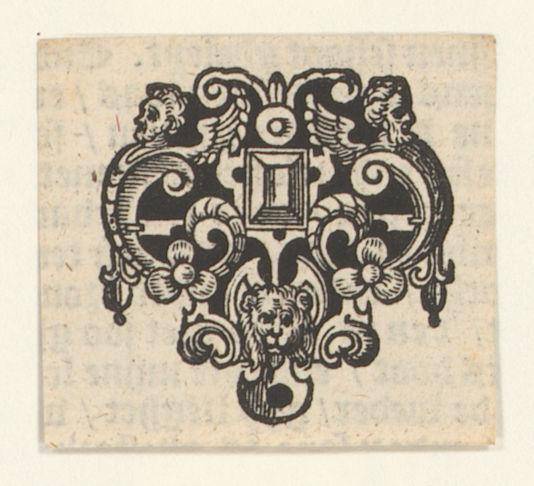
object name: album leaf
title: Ornament met twee mensenhoofden en een leeuwenkop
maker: Anonymous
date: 1592-1645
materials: paper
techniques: letterpress printing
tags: lion's head ~ ornament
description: Deze prent is gebruikt als ornament in: Paets, Pieter Jacobsz. Historien ende Prophetien wt der H. Schrifturen, met schoone Figuren door Christophorum van Sichem. Amsterdam: P.J. Paets, 1645, p. 172.